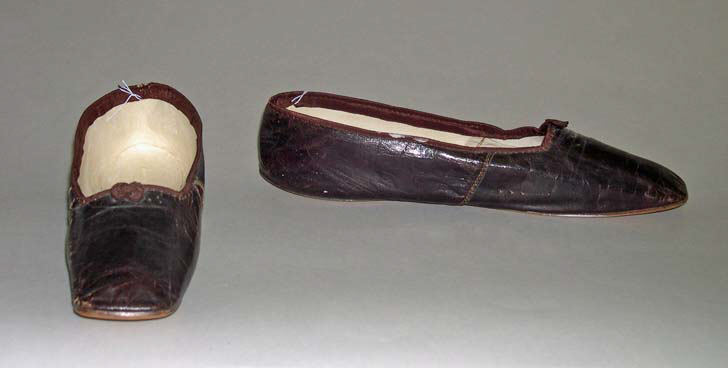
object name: shoe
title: Shoes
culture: french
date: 1840-1849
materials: leather